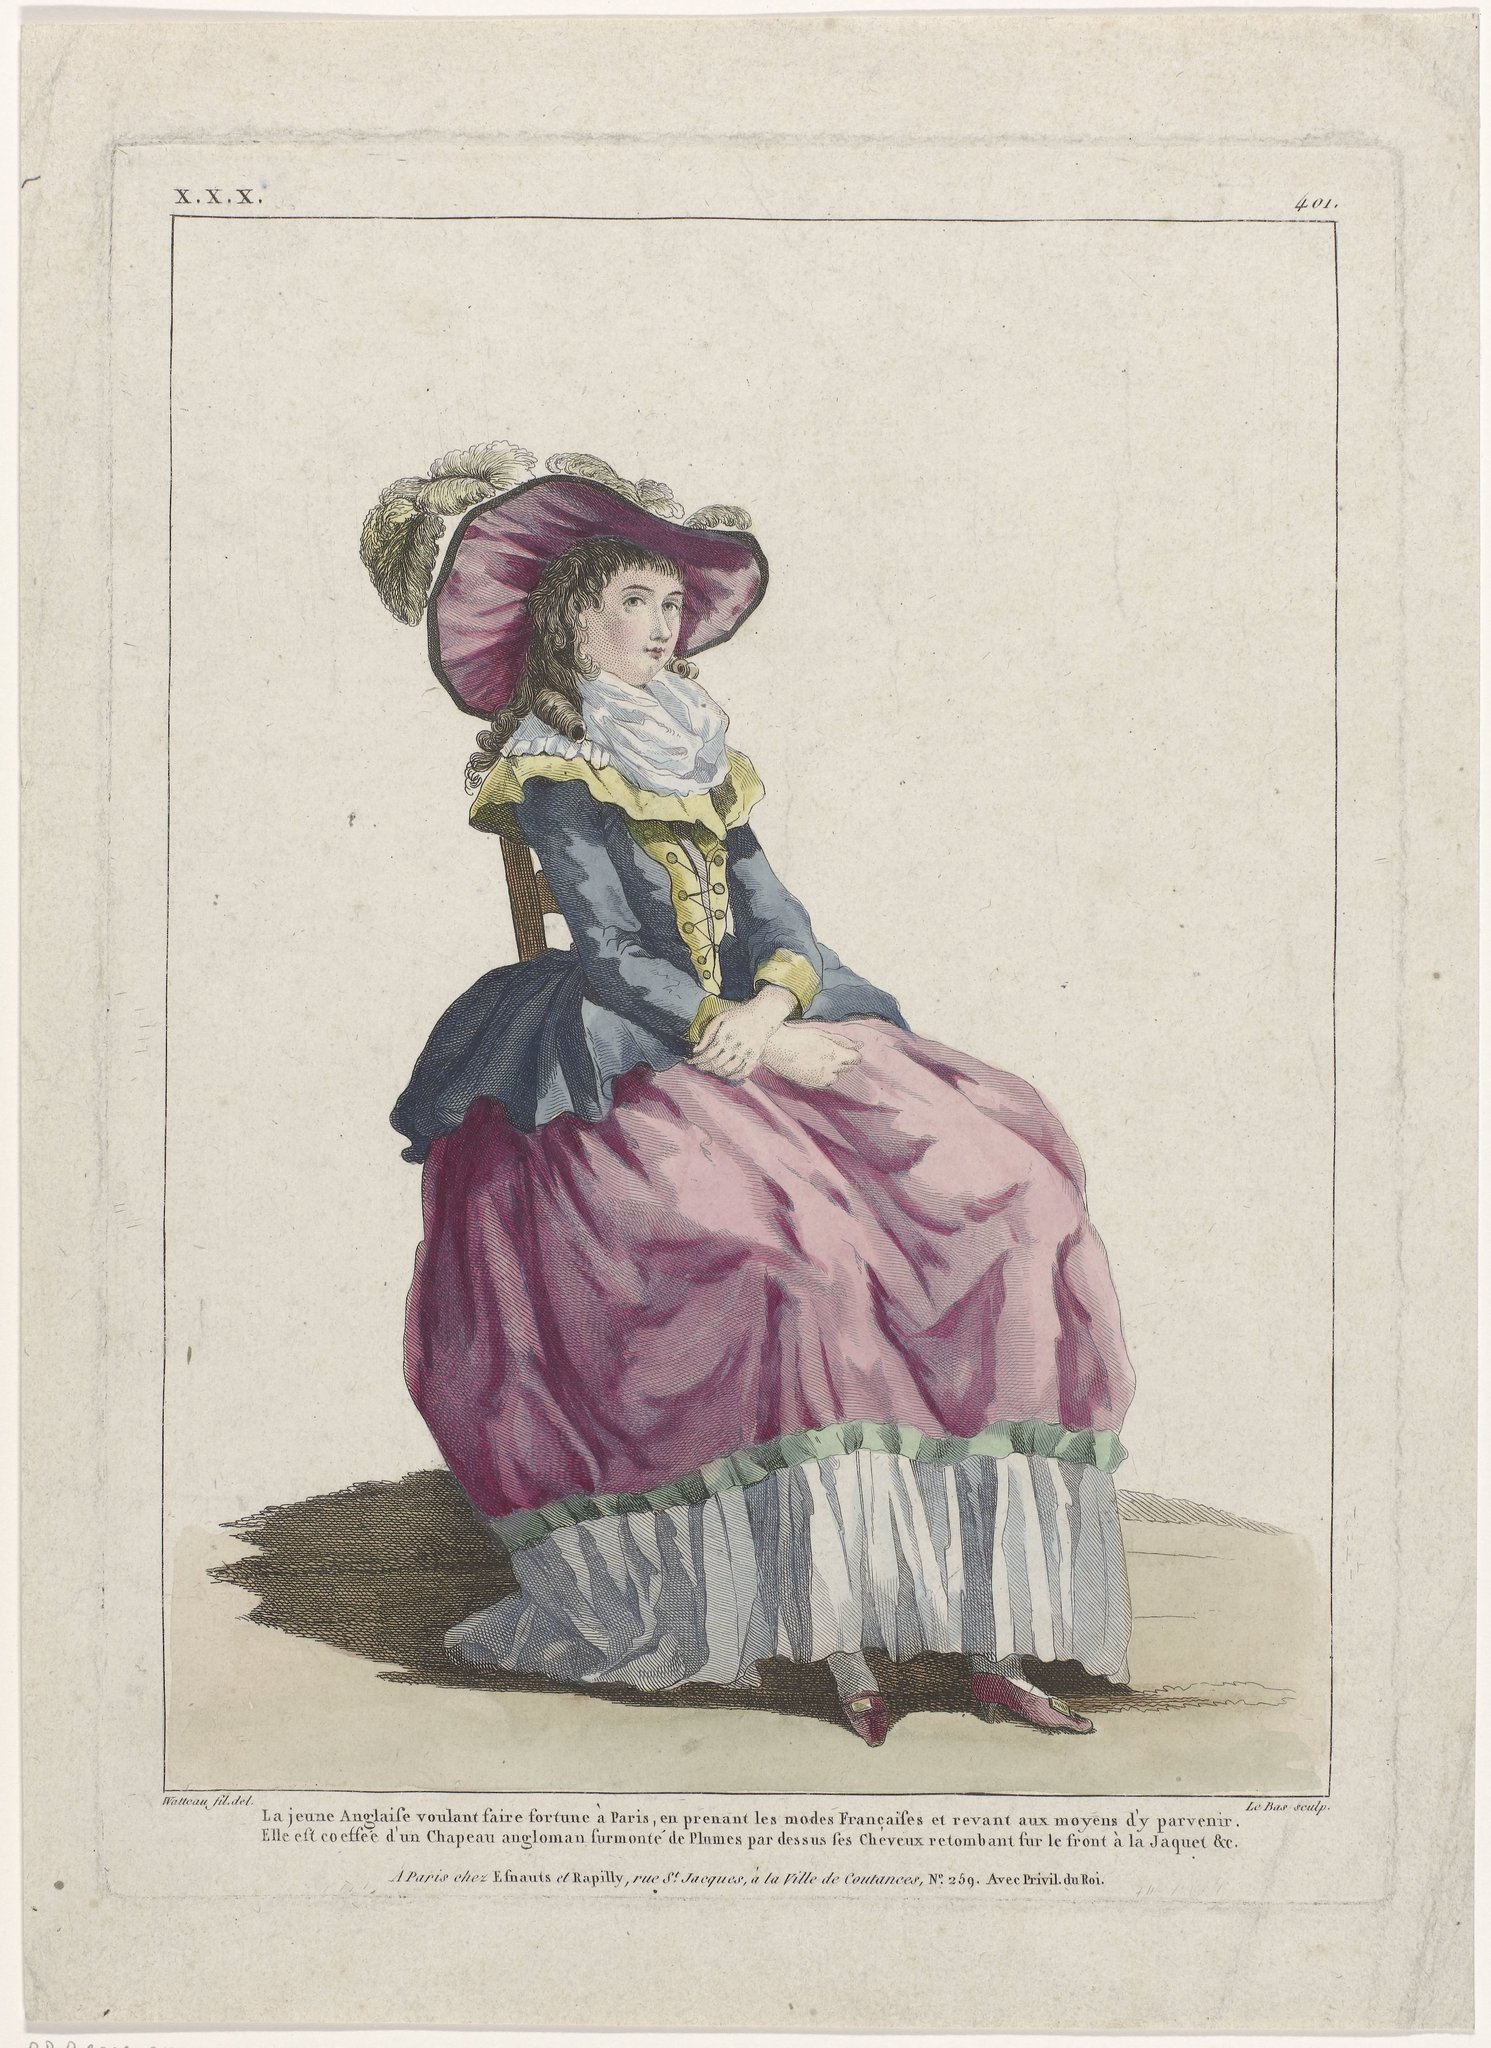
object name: fashion print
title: Gallerie des Modes et Costumes Français, 1787, xxx 401 : La jeune Anglais (...)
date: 1787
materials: paper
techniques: engraving, hand coloring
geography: paris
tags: clothing for the upper part of the body (caraco) (+ women's clothes), head-gear (chapeau à l'anglaise) (+ women's clothes), fashion plates, shoes, sandals (+ women's clothes), skirt (+ women's clothes), piece of clothing covering the breast or décolleté (fichu) (+ women's clothes), chair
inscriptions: address: ‘A Paris chez Esnauts et Rapilly, rue St. Jacques, à la Ville de Coutances,No. 259. Avec Privil. du Roi.’, caption: ‘La jeune Anglaise voulant faire fortune à Paris, en prenant les modes Françaises et revant aux moyens d'y parvenir. Elle est coeffee d'un Chapeau angloman surmonté de Plumes par dessus ses Cheveux retombant sur le front à la Jaquet &c.’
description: Een jonge Engelse vrouw met op het hoofd een hoed die 'Chapeau angloman' werd genoemd. Het golvende haar valt op het voorhoofd naar voren 'à la Jaquet'. Zij draagt een caraco met brede revers op een rok gegarneerd met een gerimpelde strook stof. Fichu. Schoenen met hakken en gespen(?). Volgens het onderschrift wil zij haar fortuin in Parijs maken. Prent uit de serie xxx. 62e Cahier de Costumes Français, Habillemens à la mode, Gallerie des Modes et Costumes Français